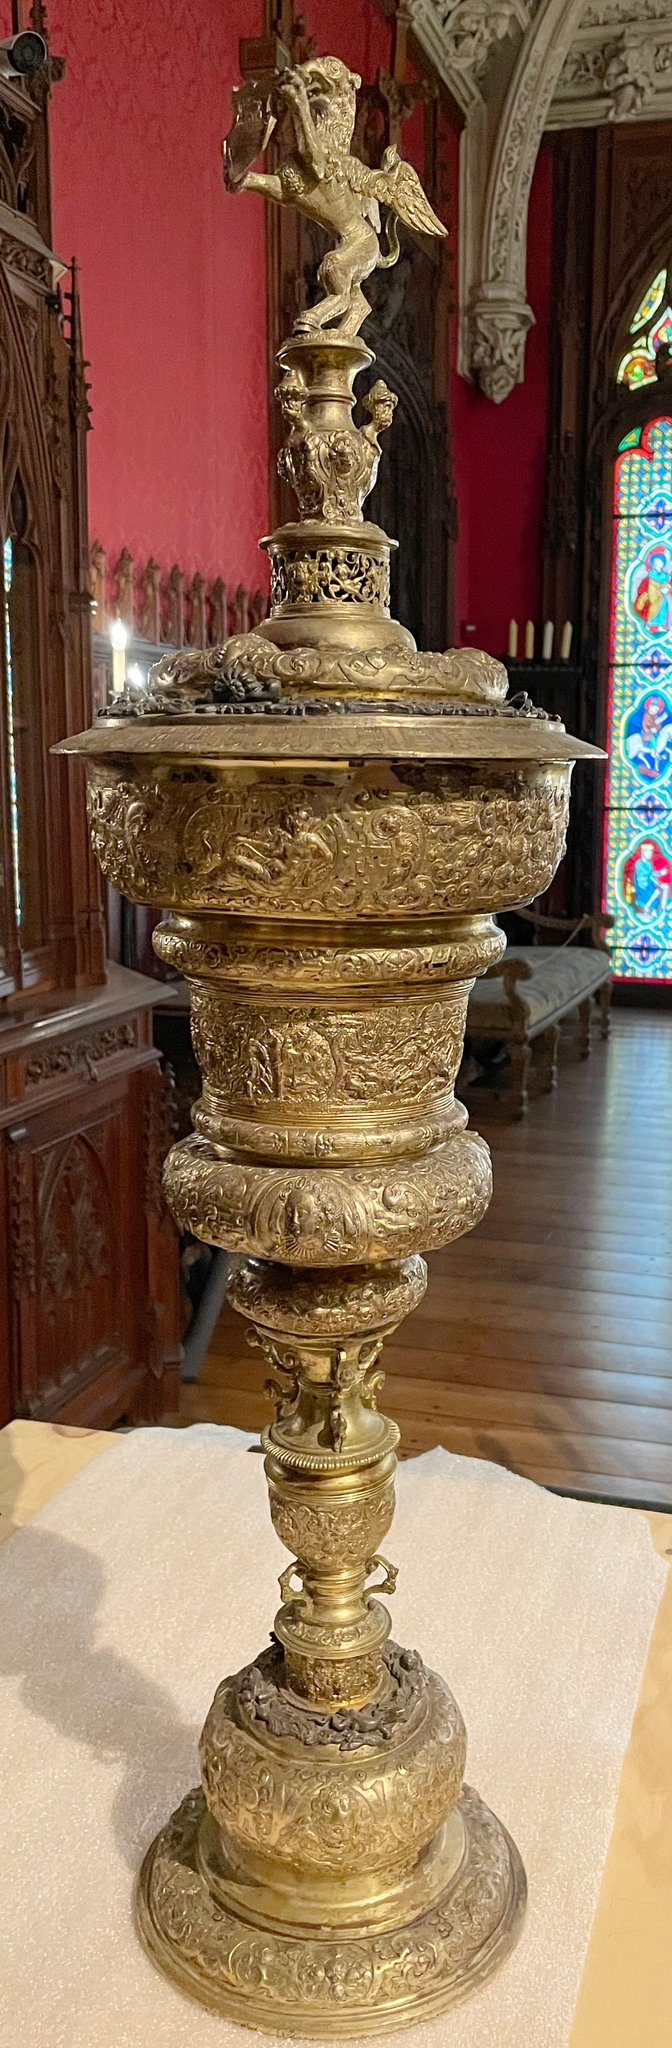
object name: cup with cover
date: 1801-1900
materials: metal, silver